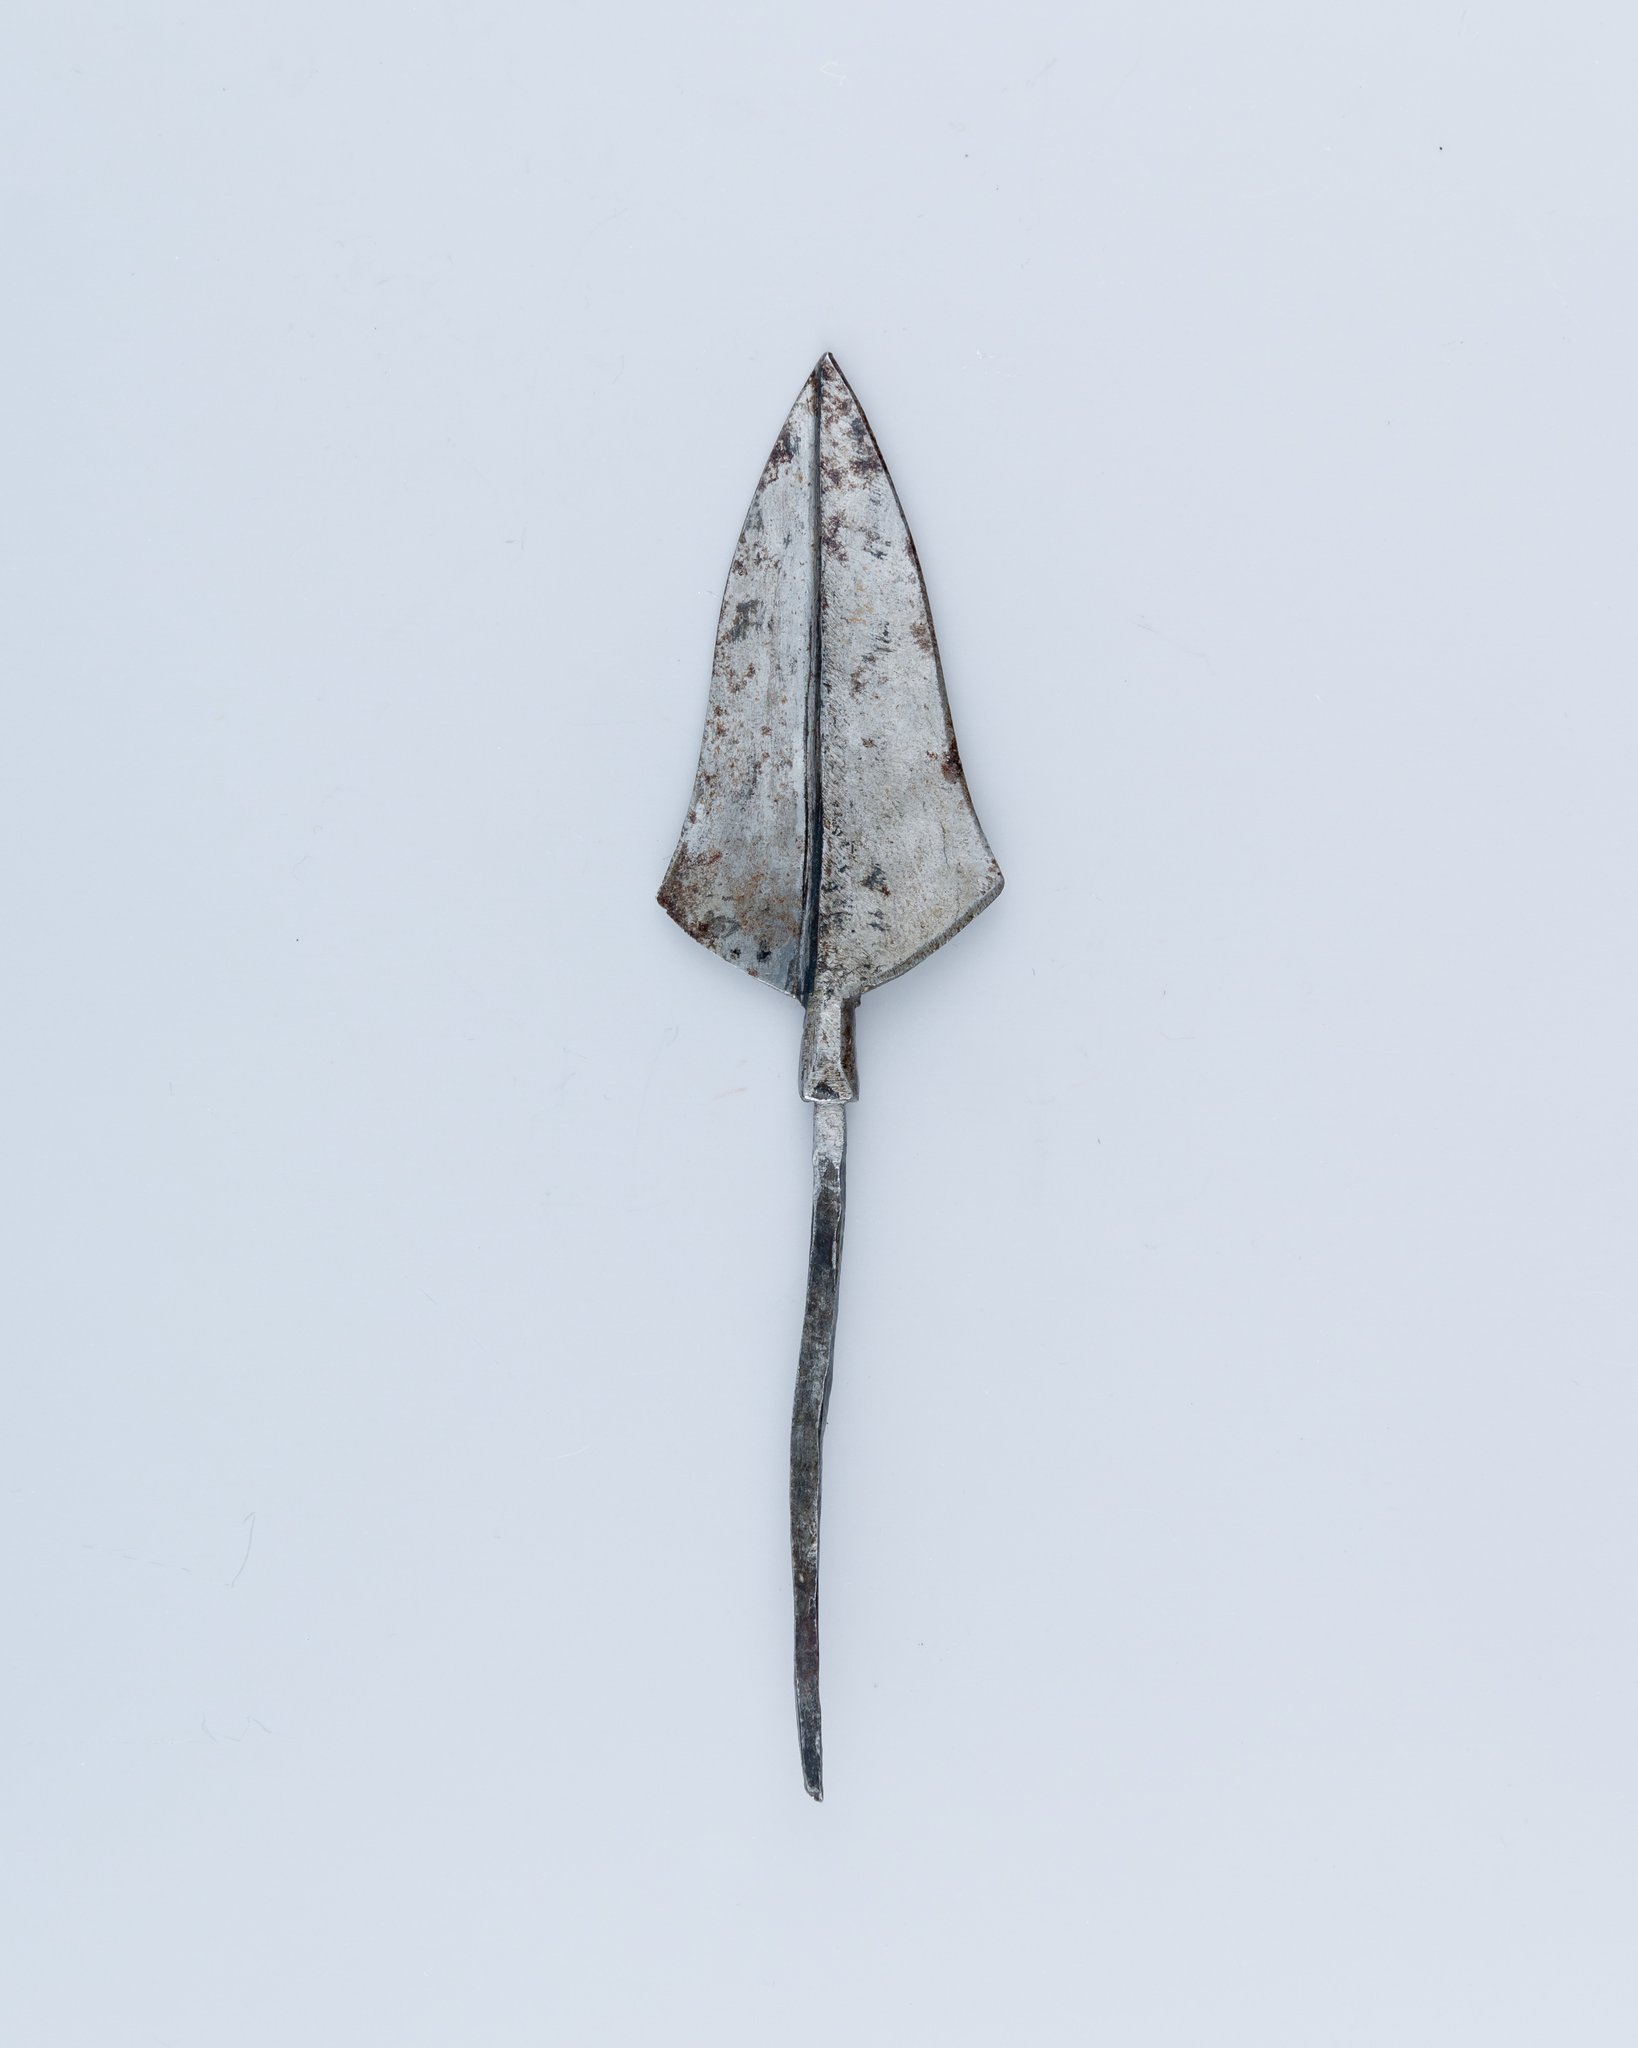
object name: arrowhead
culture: tibetan or chinese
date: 1701-1900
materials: iron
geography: china